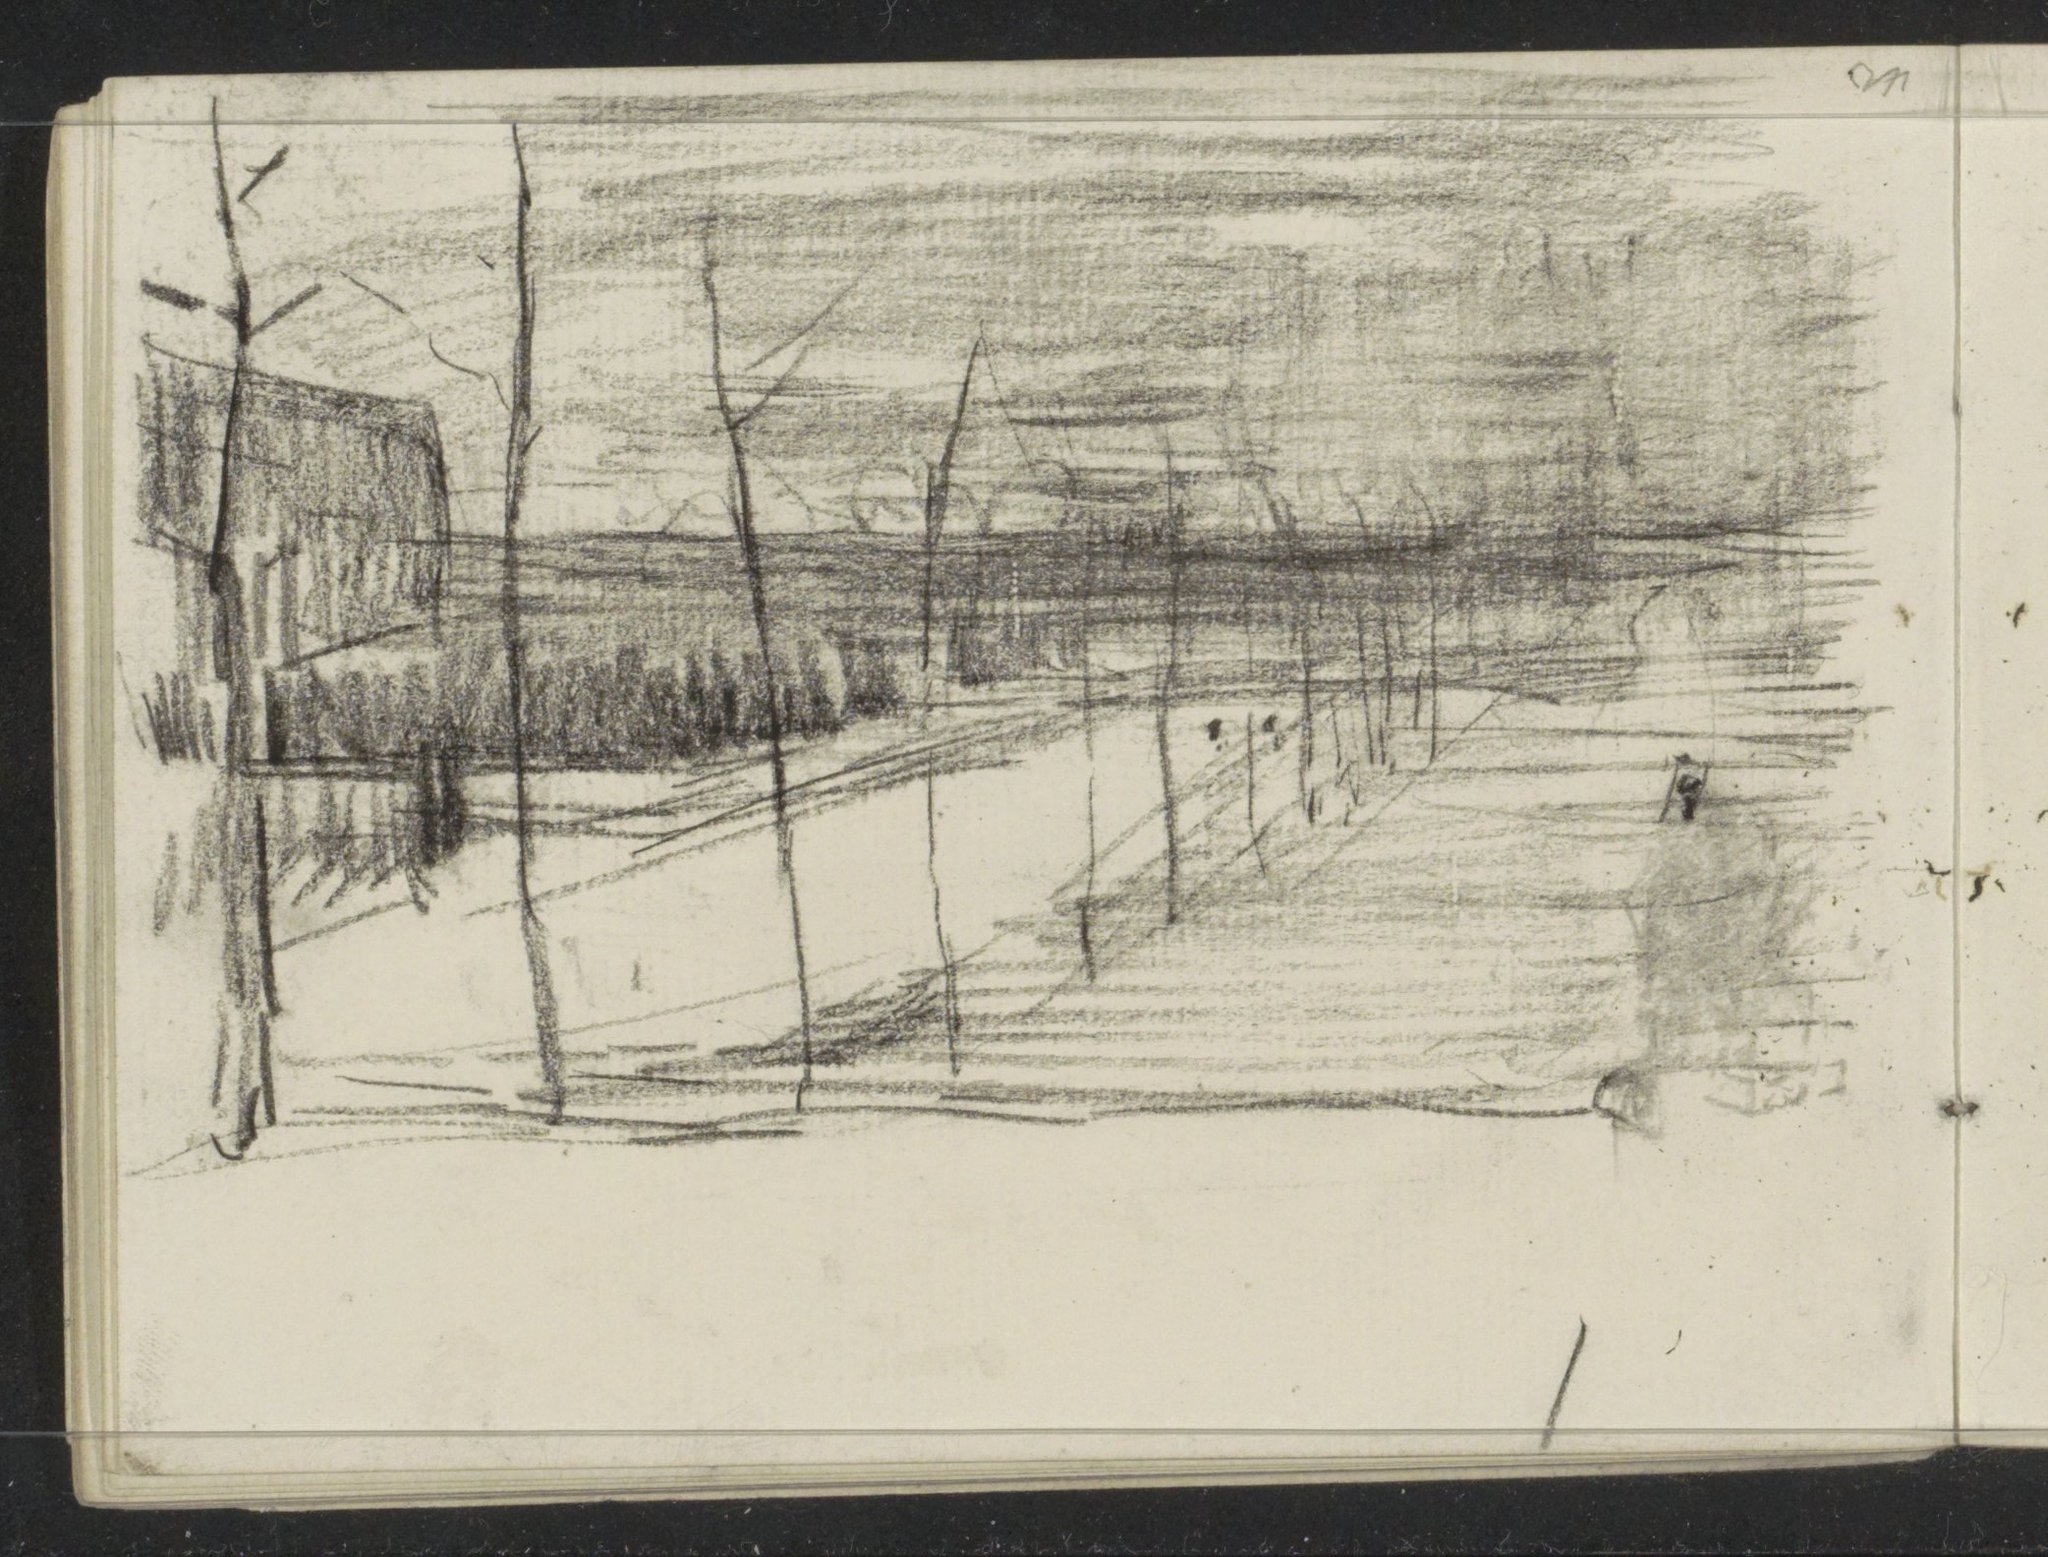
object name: sketchbook leaf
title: Vlak landschap met kale bomen en bebouwing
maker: isaac israels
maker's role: draughtsman, painter, print maker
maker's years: 1865-1934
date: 1886-1934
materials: chalk, paper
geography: amsterdam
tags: landscapes in the temperate zone, architecture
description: Blad 19 verso uit schetsboek LXIV met 29 bladen.